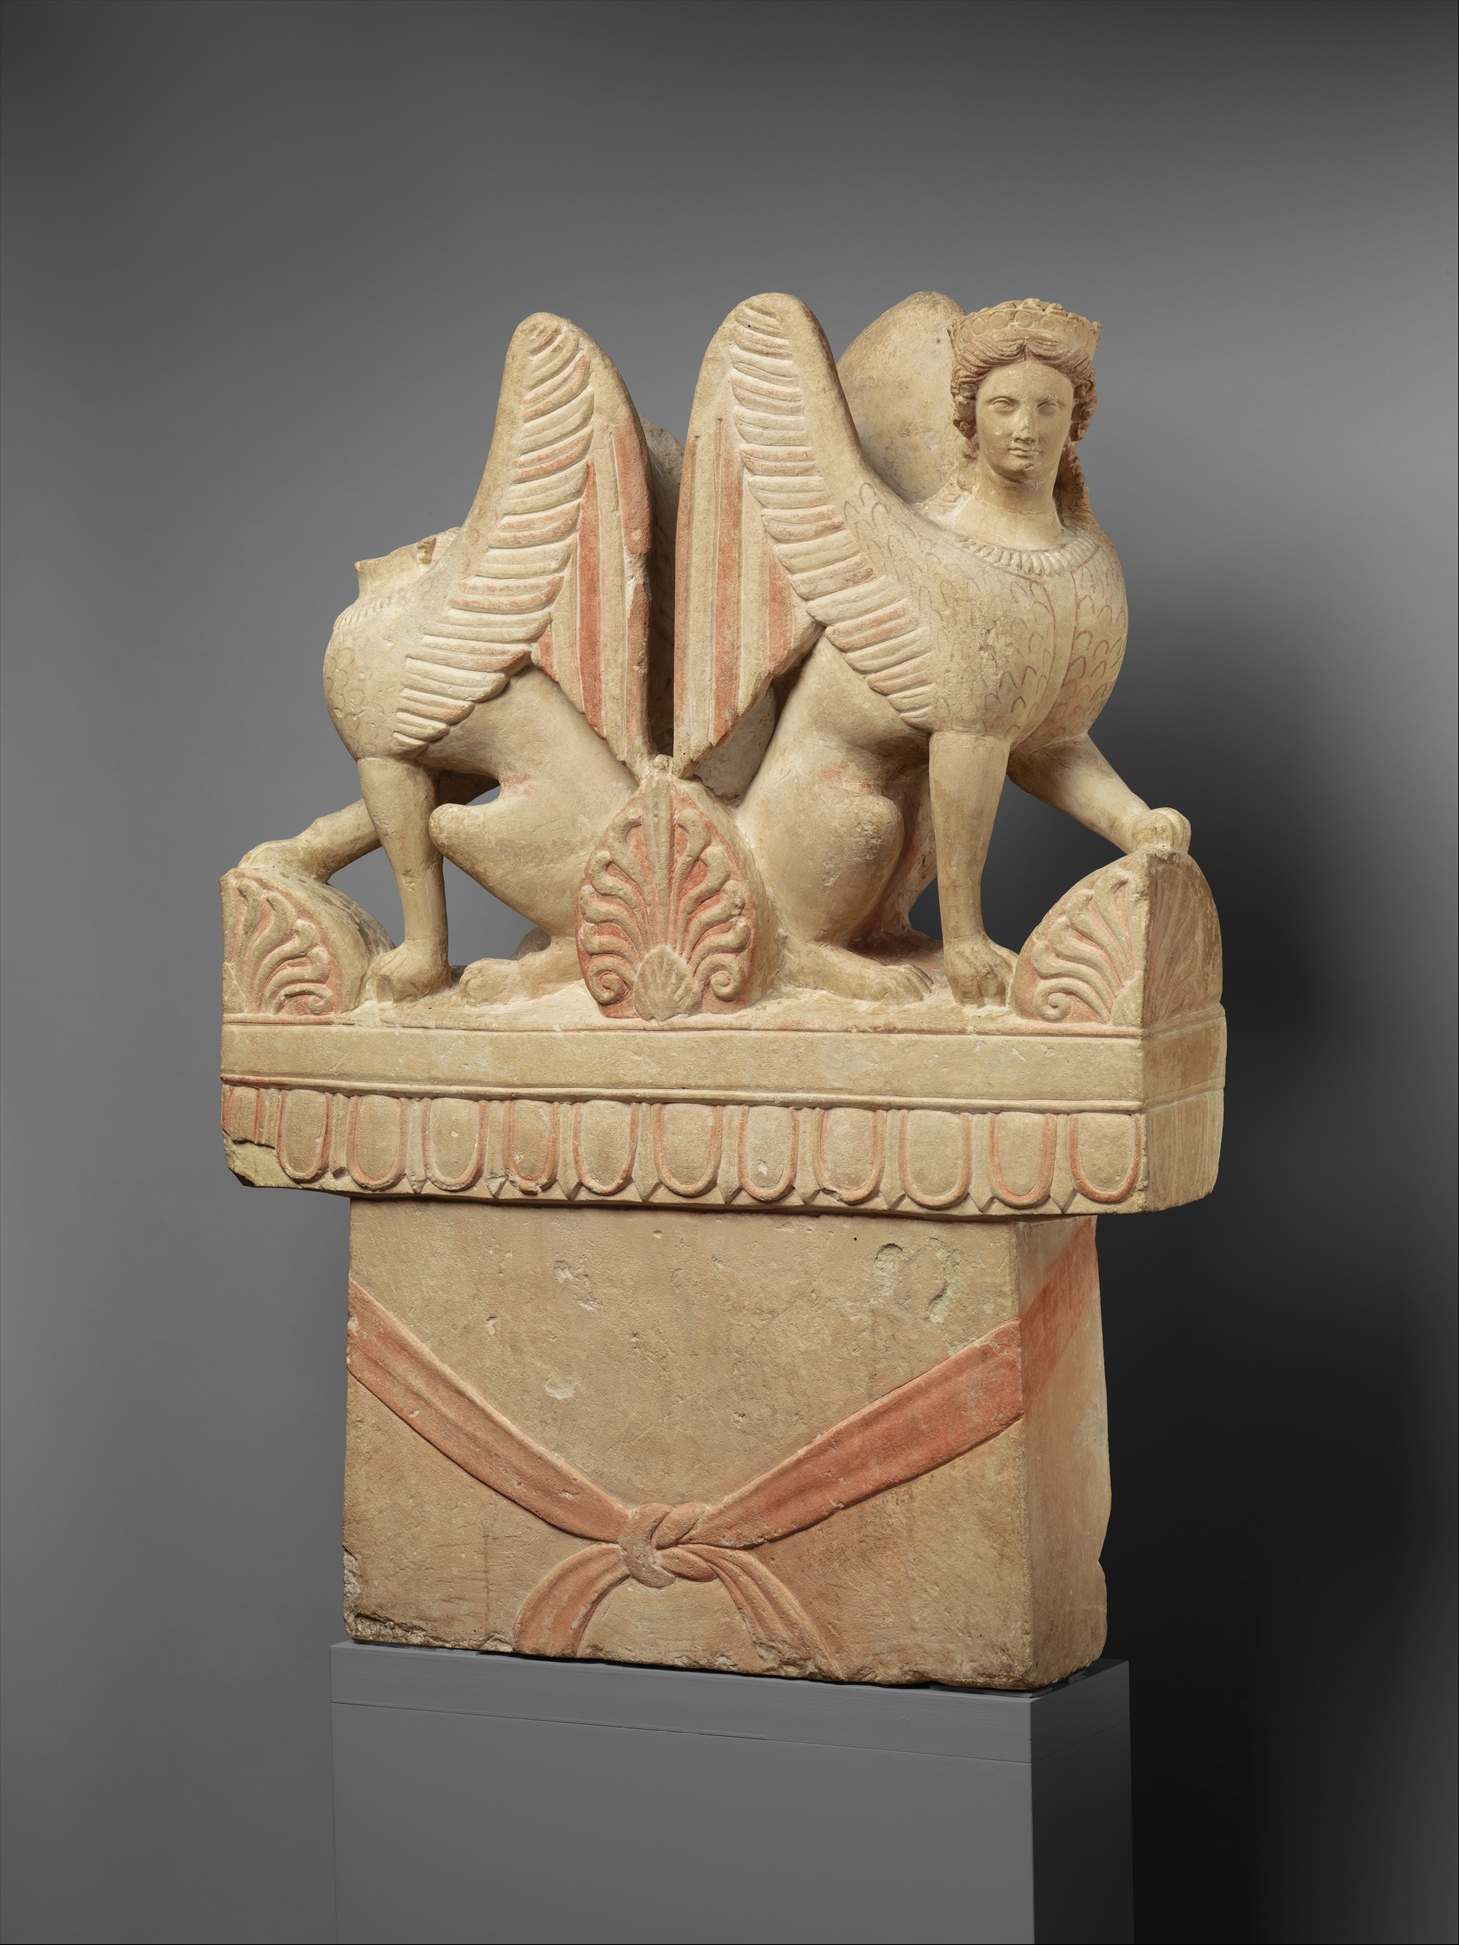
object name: grave stele with two sphinx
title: Limestone funerary stele (shaft) surmounted by two sphinxes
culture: cypriot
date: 425-401 BCE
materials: limestone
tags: sphinx